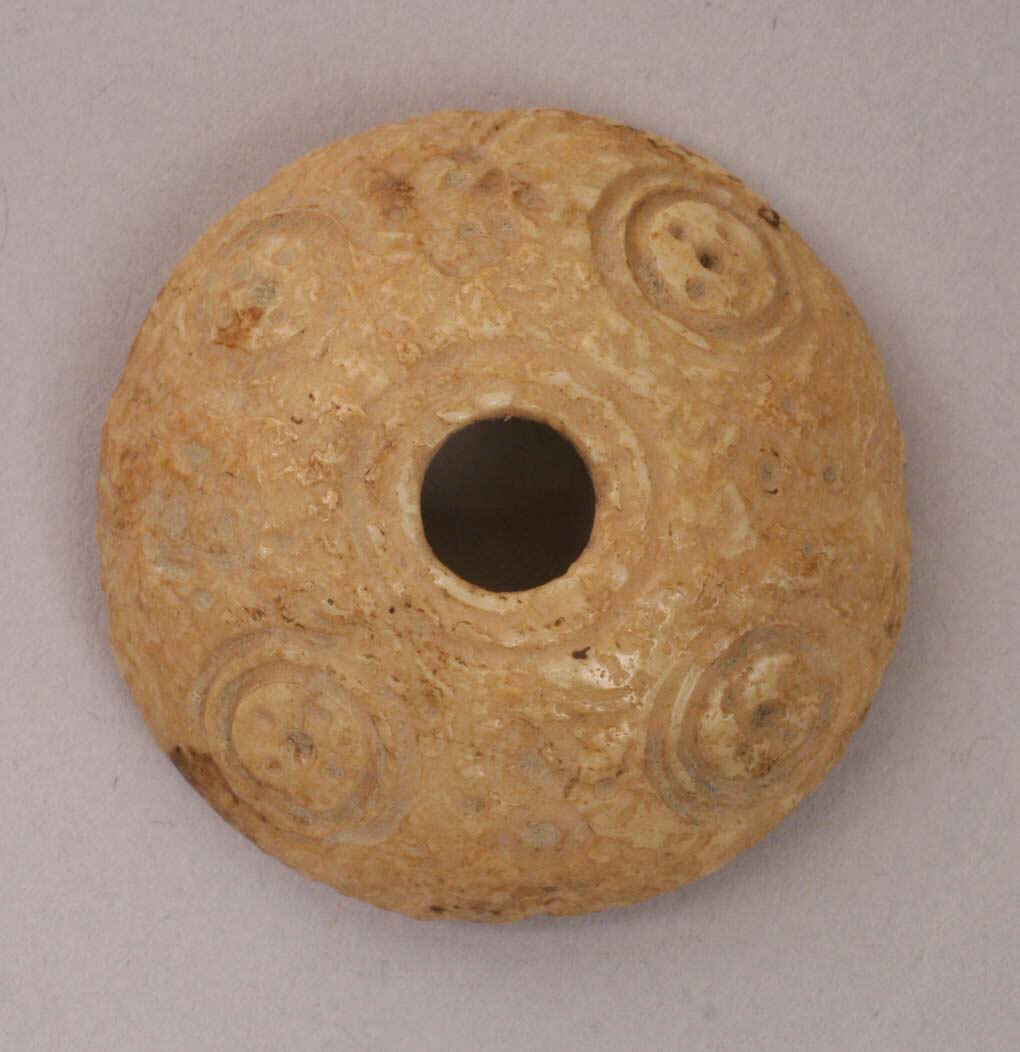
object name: spindle whorl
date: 701-1000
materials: bone, paint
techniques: incising, inlay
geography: iran